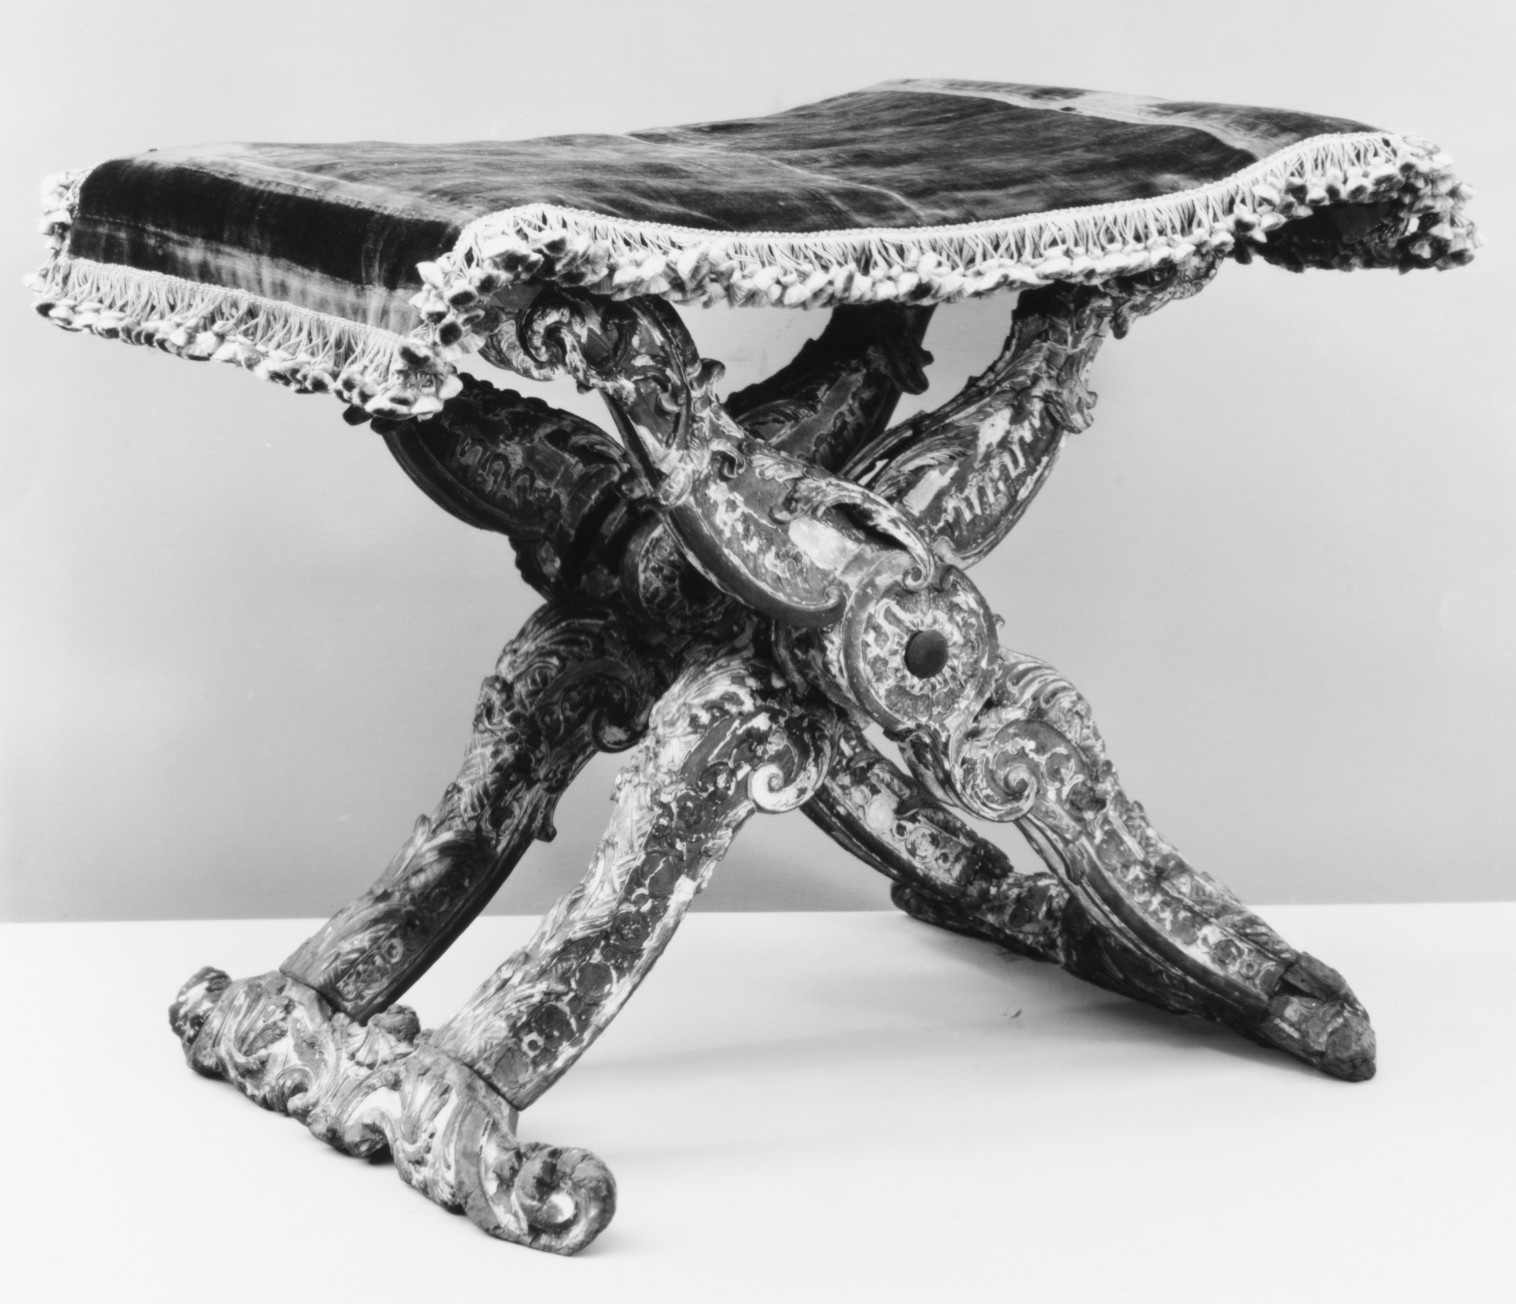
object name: stool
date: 1701-1800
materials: velvet, wood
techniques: carving, gilding